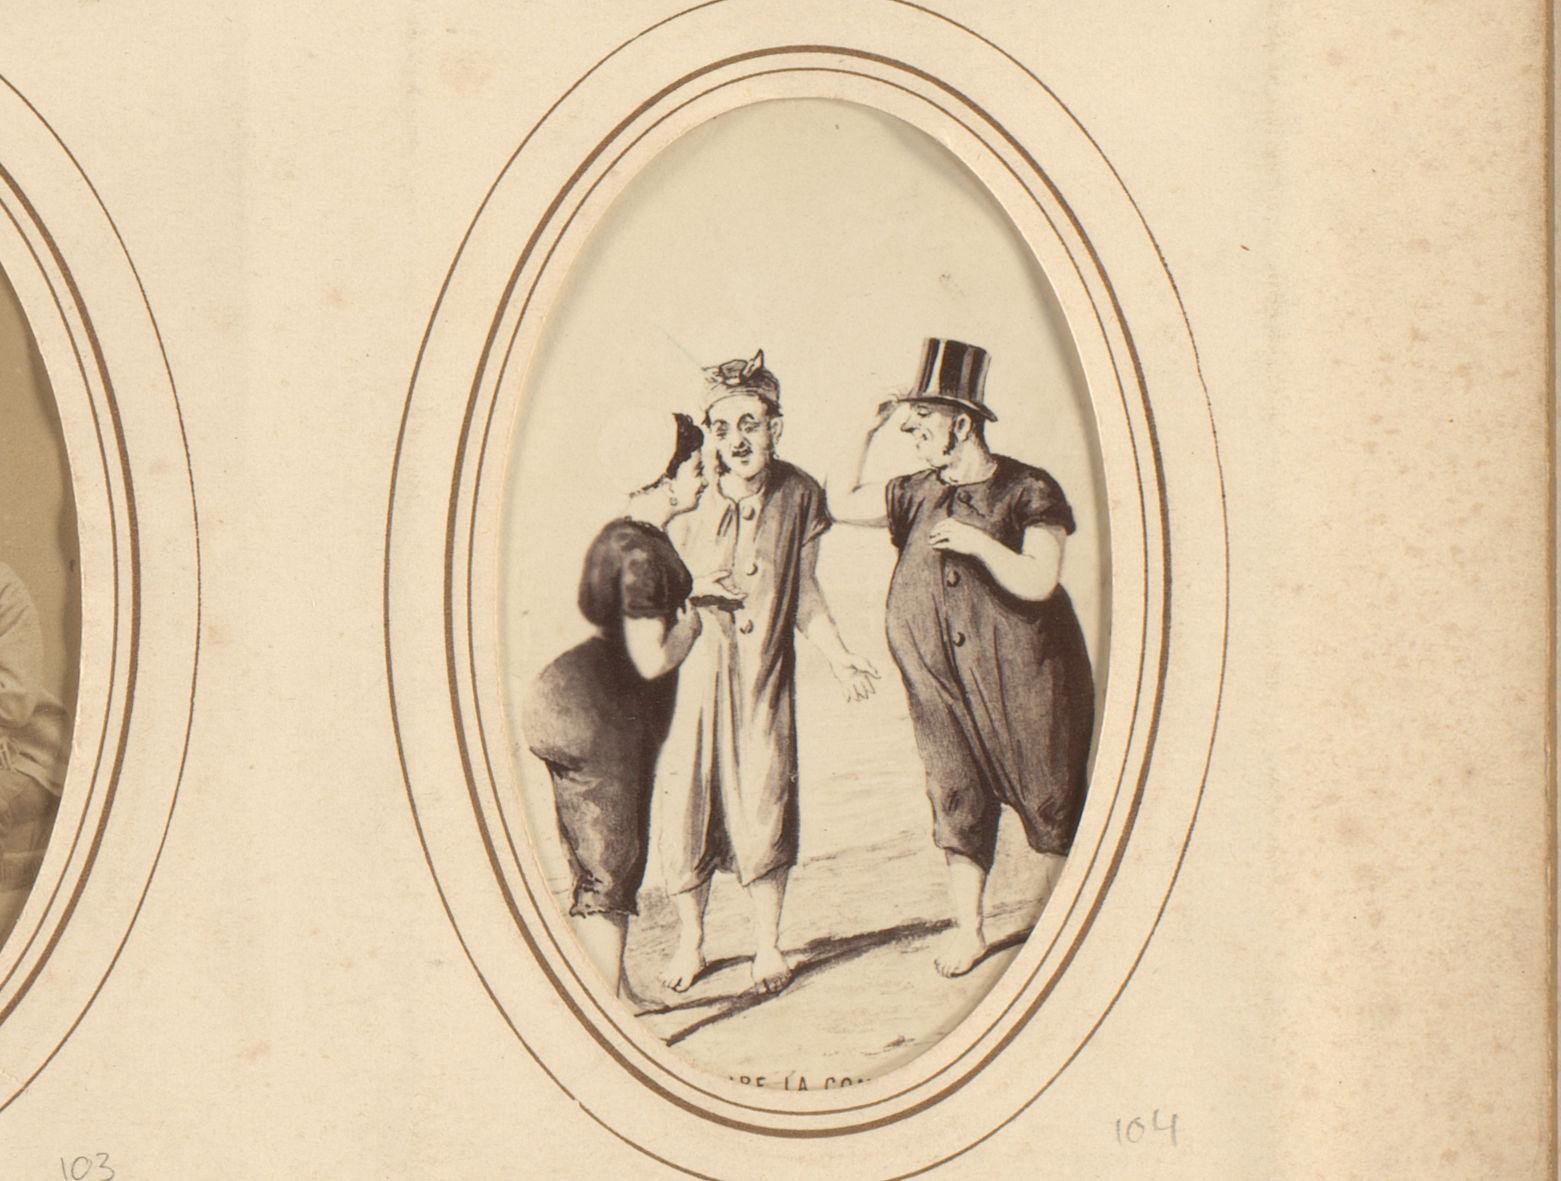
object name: reproduction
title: Fotoreproductie van een ontwerp met de afbeelding van drie personen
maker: Anonymous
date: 1865-1890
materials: cardboard, photographic support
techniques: albumen print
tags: adult woman, adult man